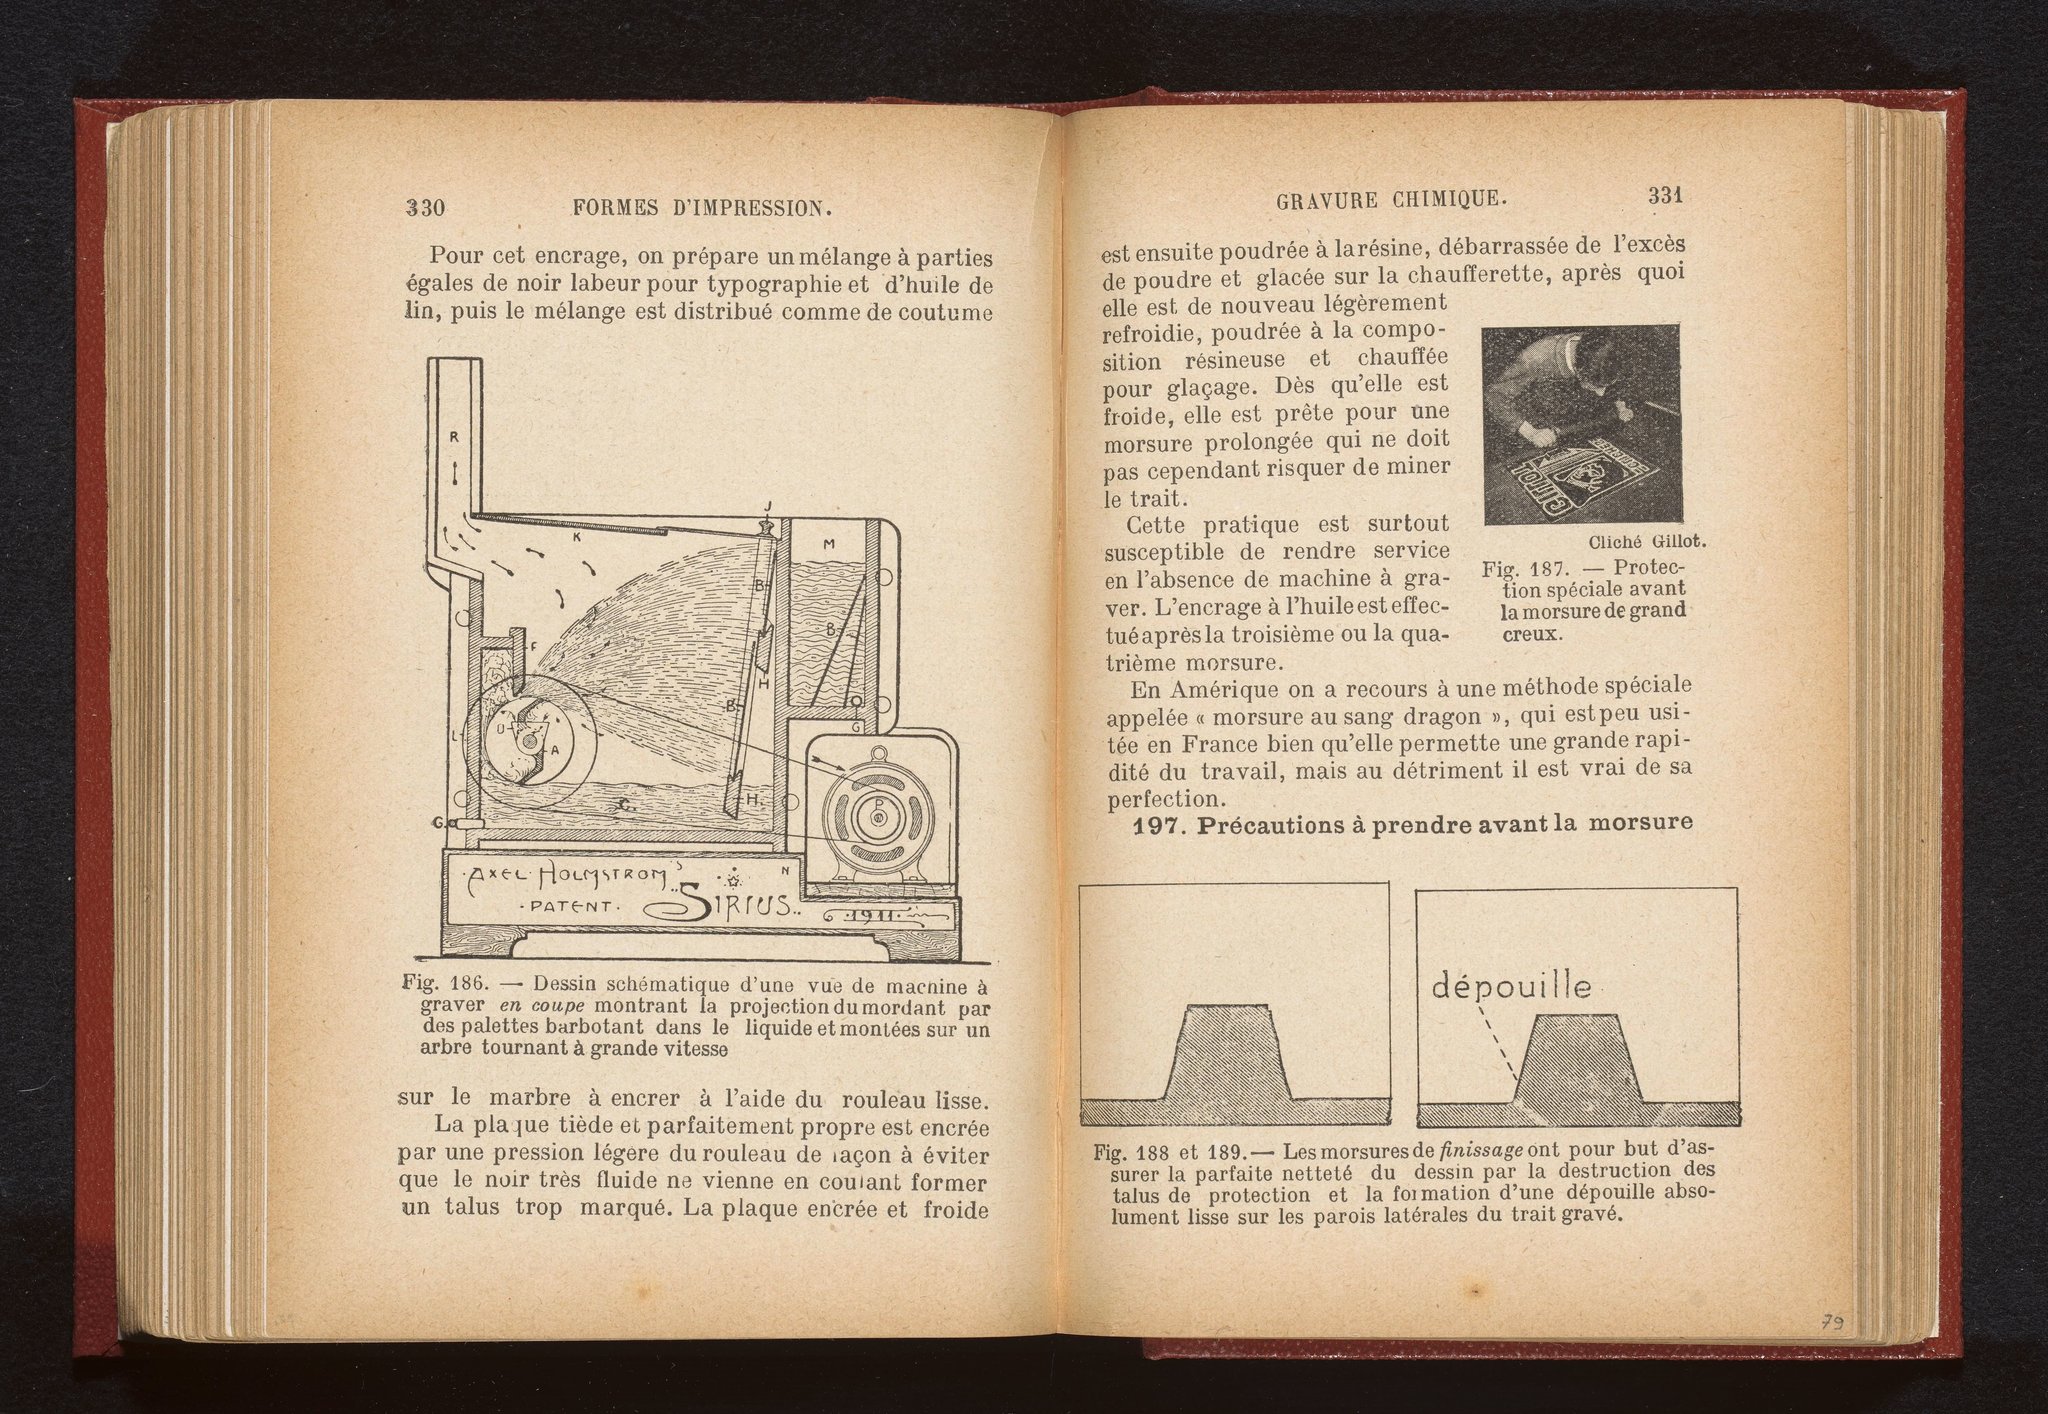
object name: page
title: Man die een beschermlaag aanbrengt op een plaat voor een fotomechanische afdruk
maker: Anonymous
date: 1922-1932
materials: paper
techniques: autotype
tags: print, e.g.: engraving, etching, lithograph, photographic apparatus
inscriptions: number: ‘Fig. 187.’